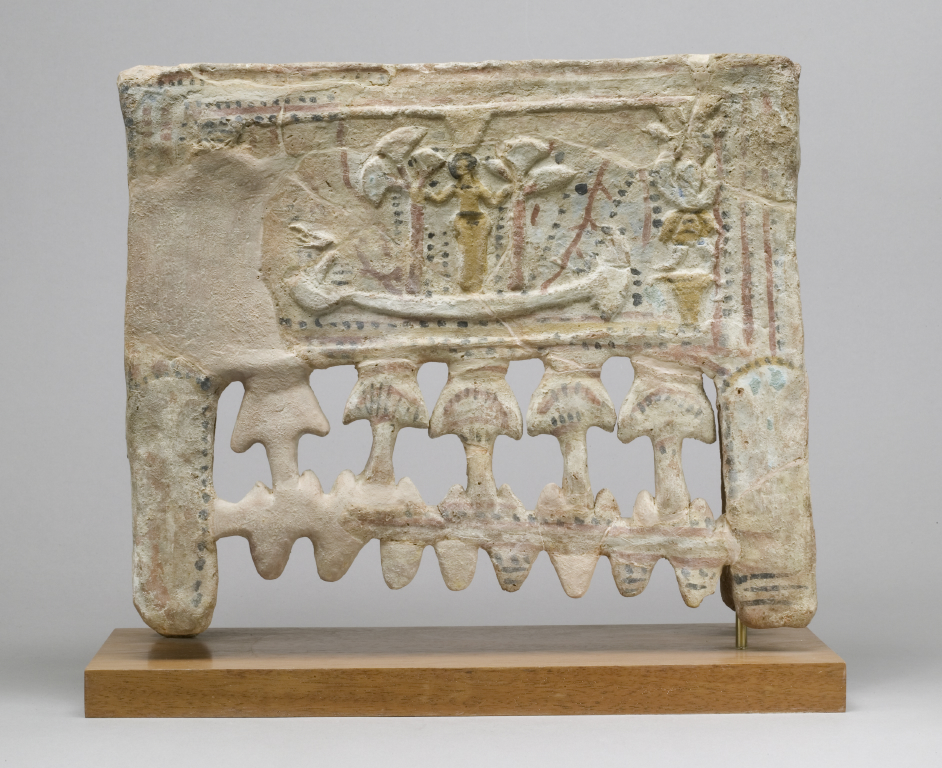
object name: votive bed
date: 945-715 BCE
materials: paint, pottery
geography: egypt